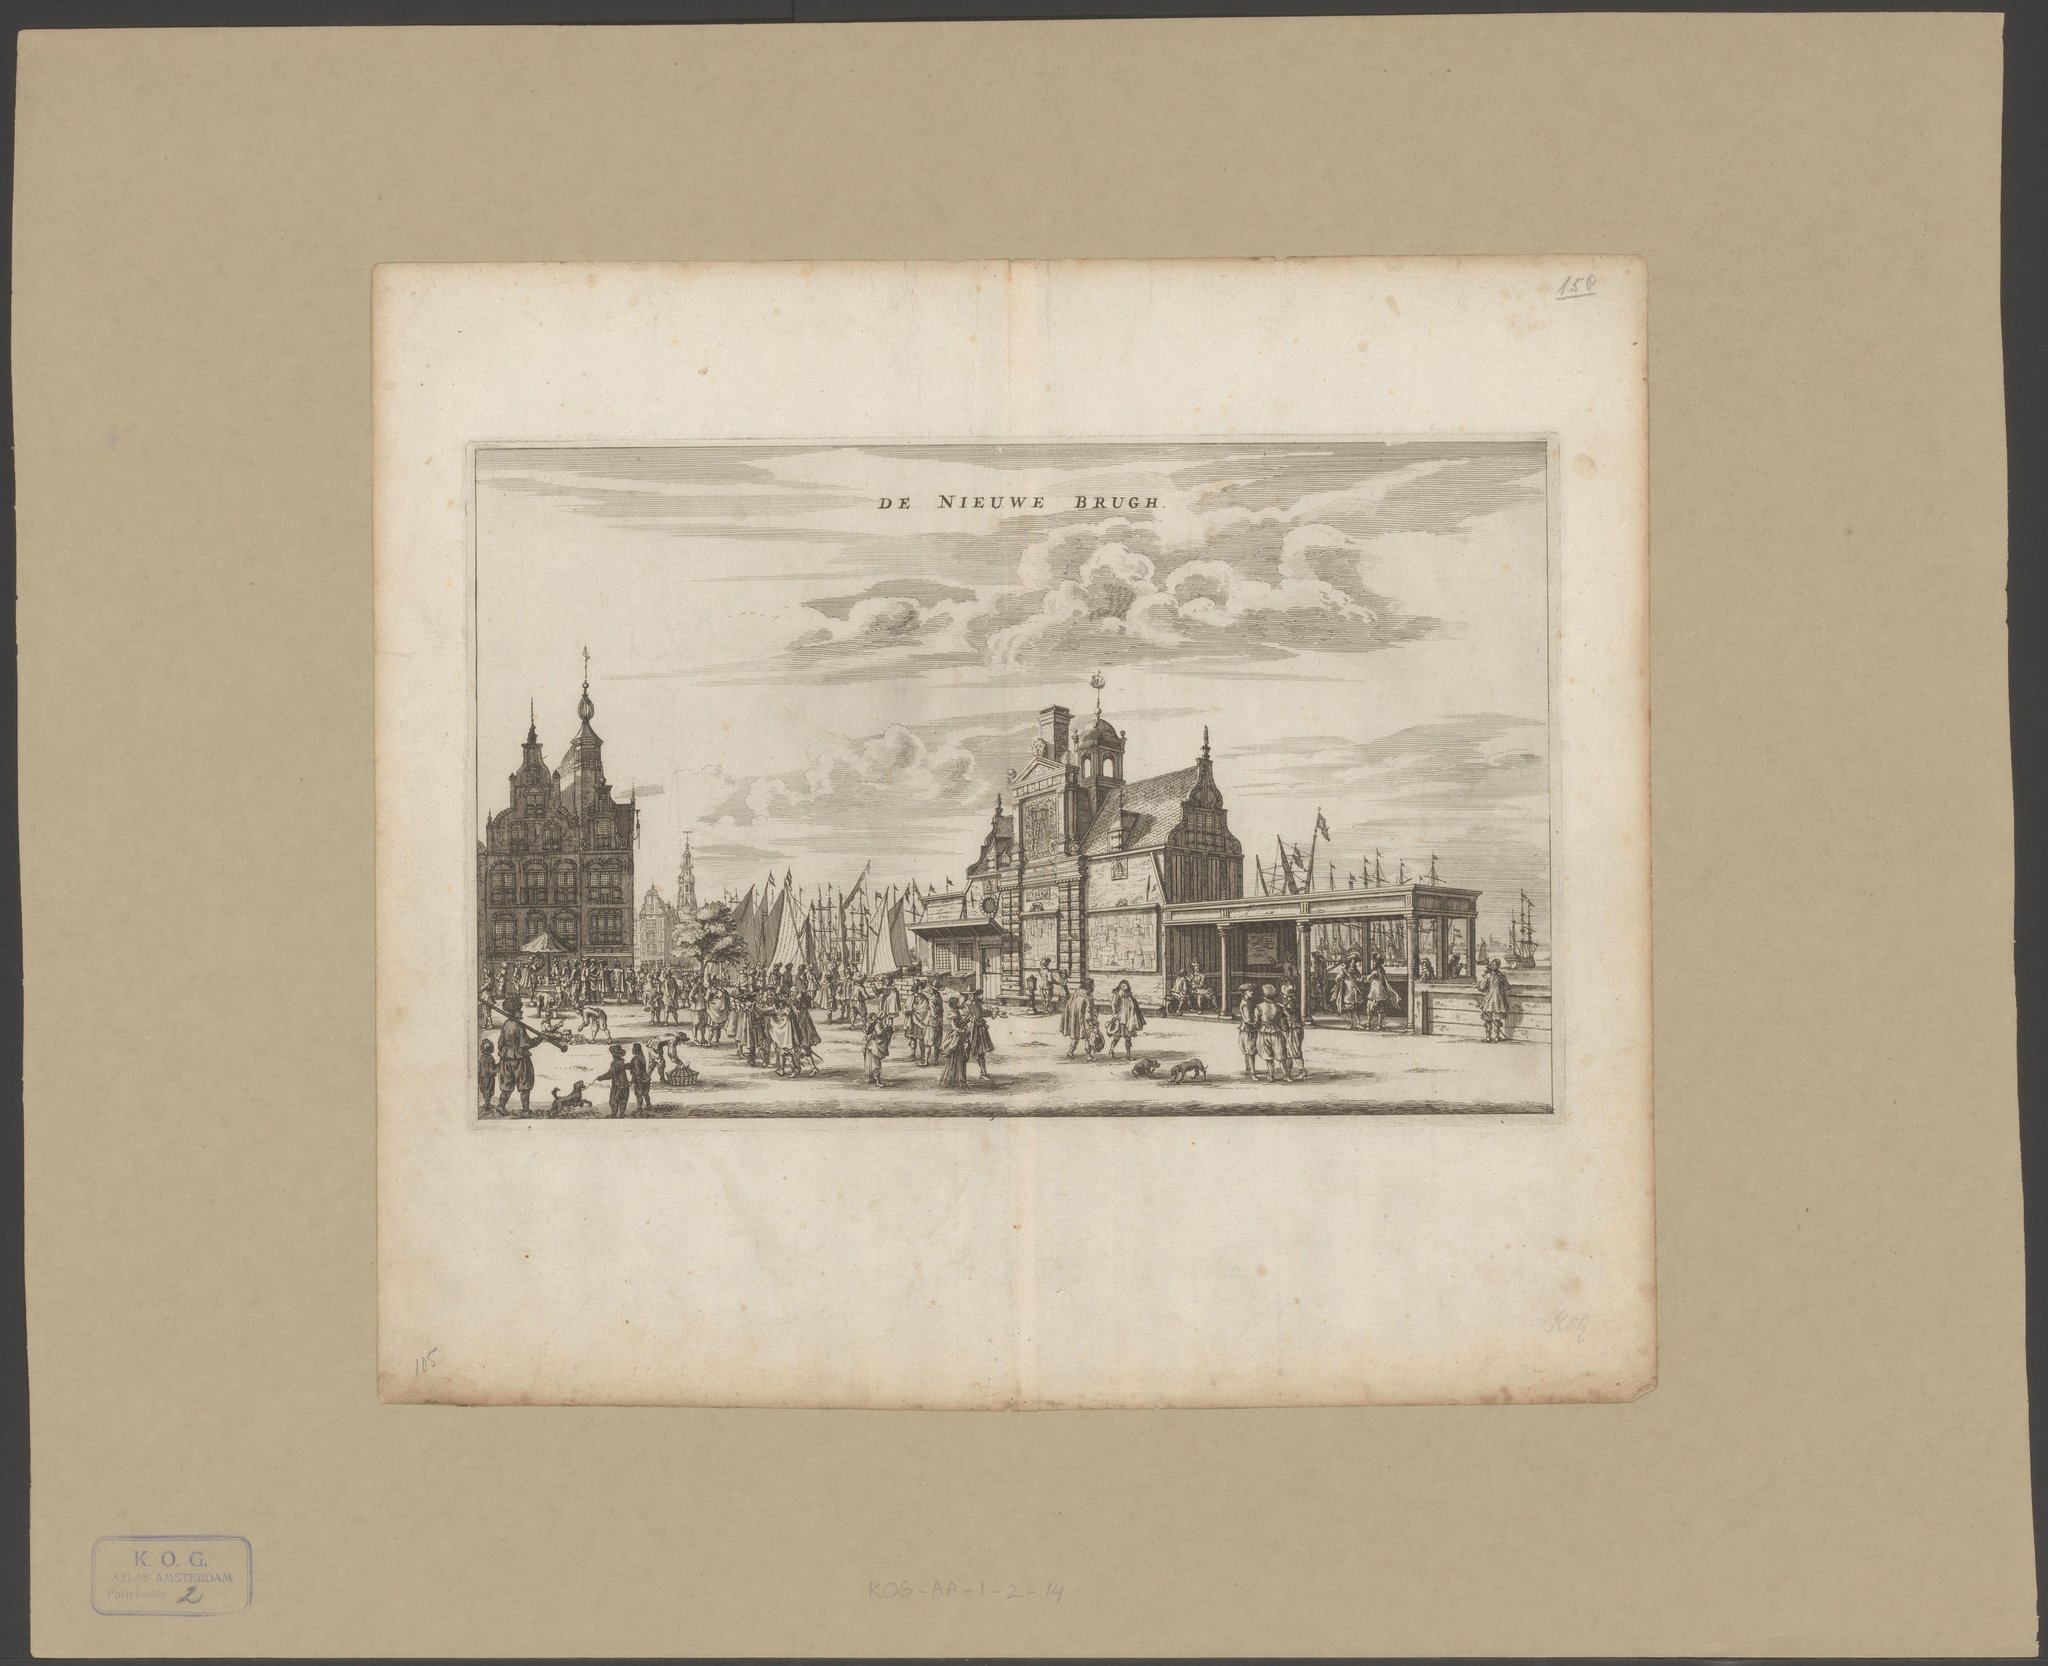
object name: print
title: Gezicht op het Paalhuis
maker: jacob van meurs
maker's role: draughtsman, print maker, publisher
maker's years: 1619-1680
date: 1663-1664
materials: paper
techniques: engraving, etching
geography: amsterdam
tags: post-office, tower, clock tower ~ monumental adornment, city-view in general; 'veduta', street, taxes and financial administration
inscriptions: collector's mark: ‘2’ Lugt 1641b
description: Huidige staat van prent ook gebruikt in: Dapper, Olfert. Historische beschryving der stadt Amsterdam: waer in de voornaemste geschiedenissen (na een kort verhael van gansch Hollant en d'omleggende dorpen (…). Amsterdam: Jacob van Meurs, 1663.* En in: Zesen, Philipp von. Beschreibung der Stadt Amsterdam: darinnen von derselben ersten Ursprunge bis auf gegenwärtigen Zustand (…). Amsterdam: Joachim Nosche, 1664. * In sommige exemplaren van deze uitgave komt de huidige staat van de prent voor. In andere exemplaren is een latere staat ingebonden, waarop boven de Nederlandse een Franse titel is toegevoegd. Zie ook SK-A-20 en RP-P-AO-27-48-2.